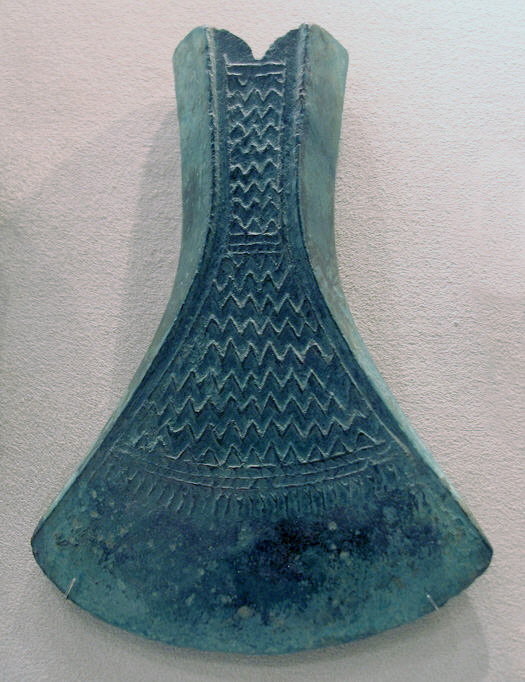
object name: ax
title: Swallowtail Hafted Ax with Chevron Design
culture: indonesian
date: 500 BCE-300 CE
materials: bronze